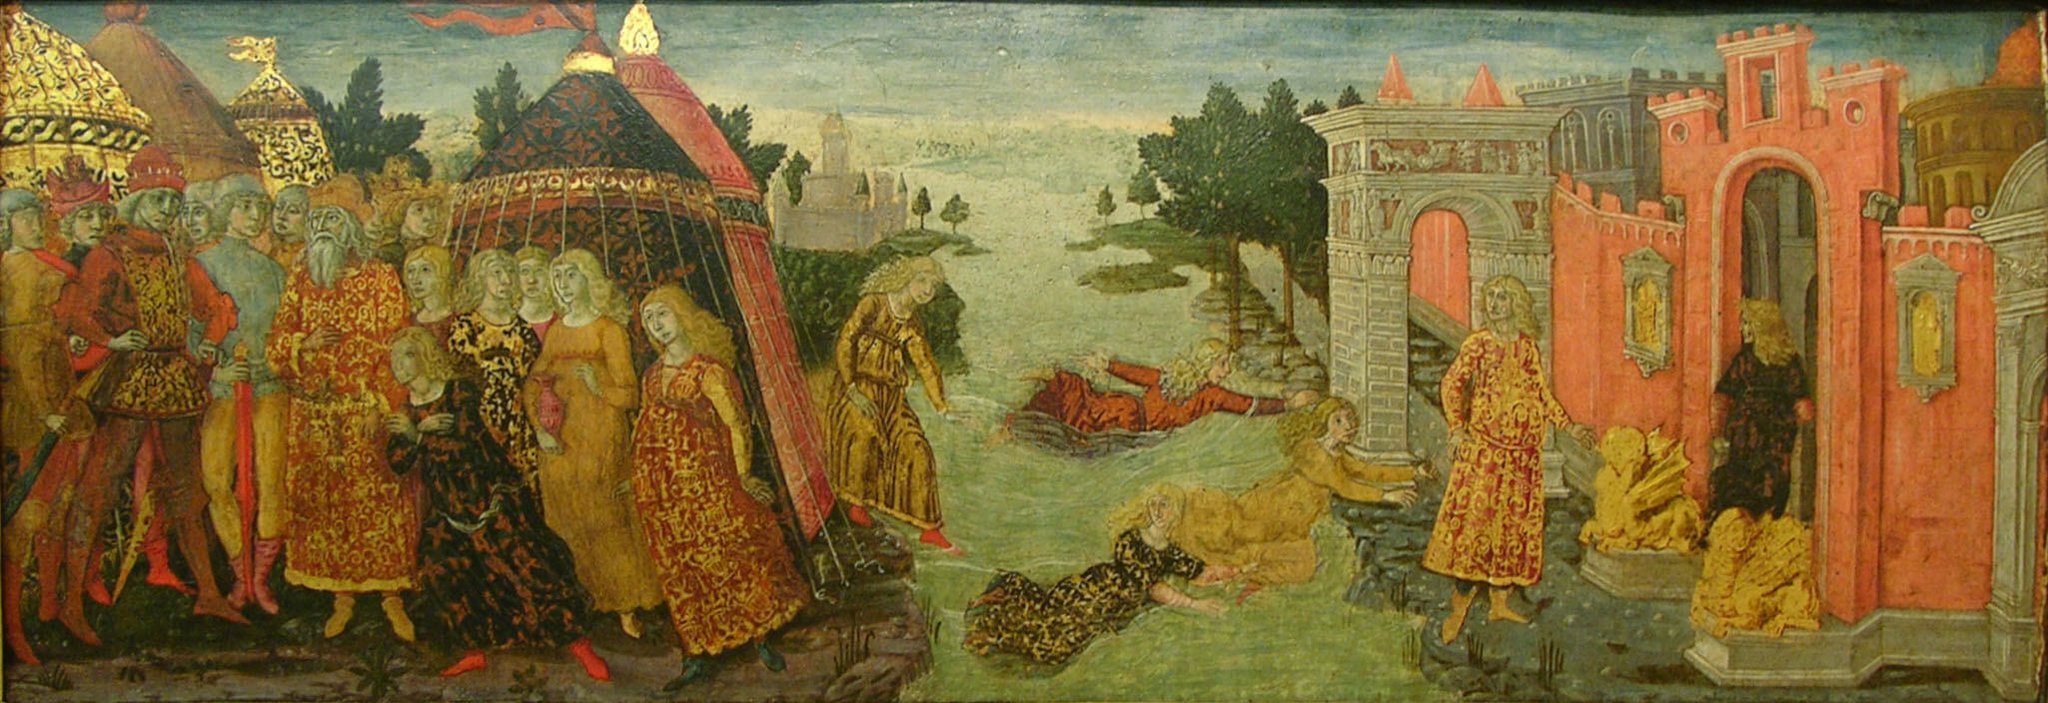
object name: painting, cassone panel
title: The Legend of Cloelia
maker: guidoccio di giovanni cozzarelli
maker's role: artist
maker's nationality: italian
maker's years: 1450-1516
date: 1480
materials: gold, paint, wood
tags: men,women,rivers,bathing